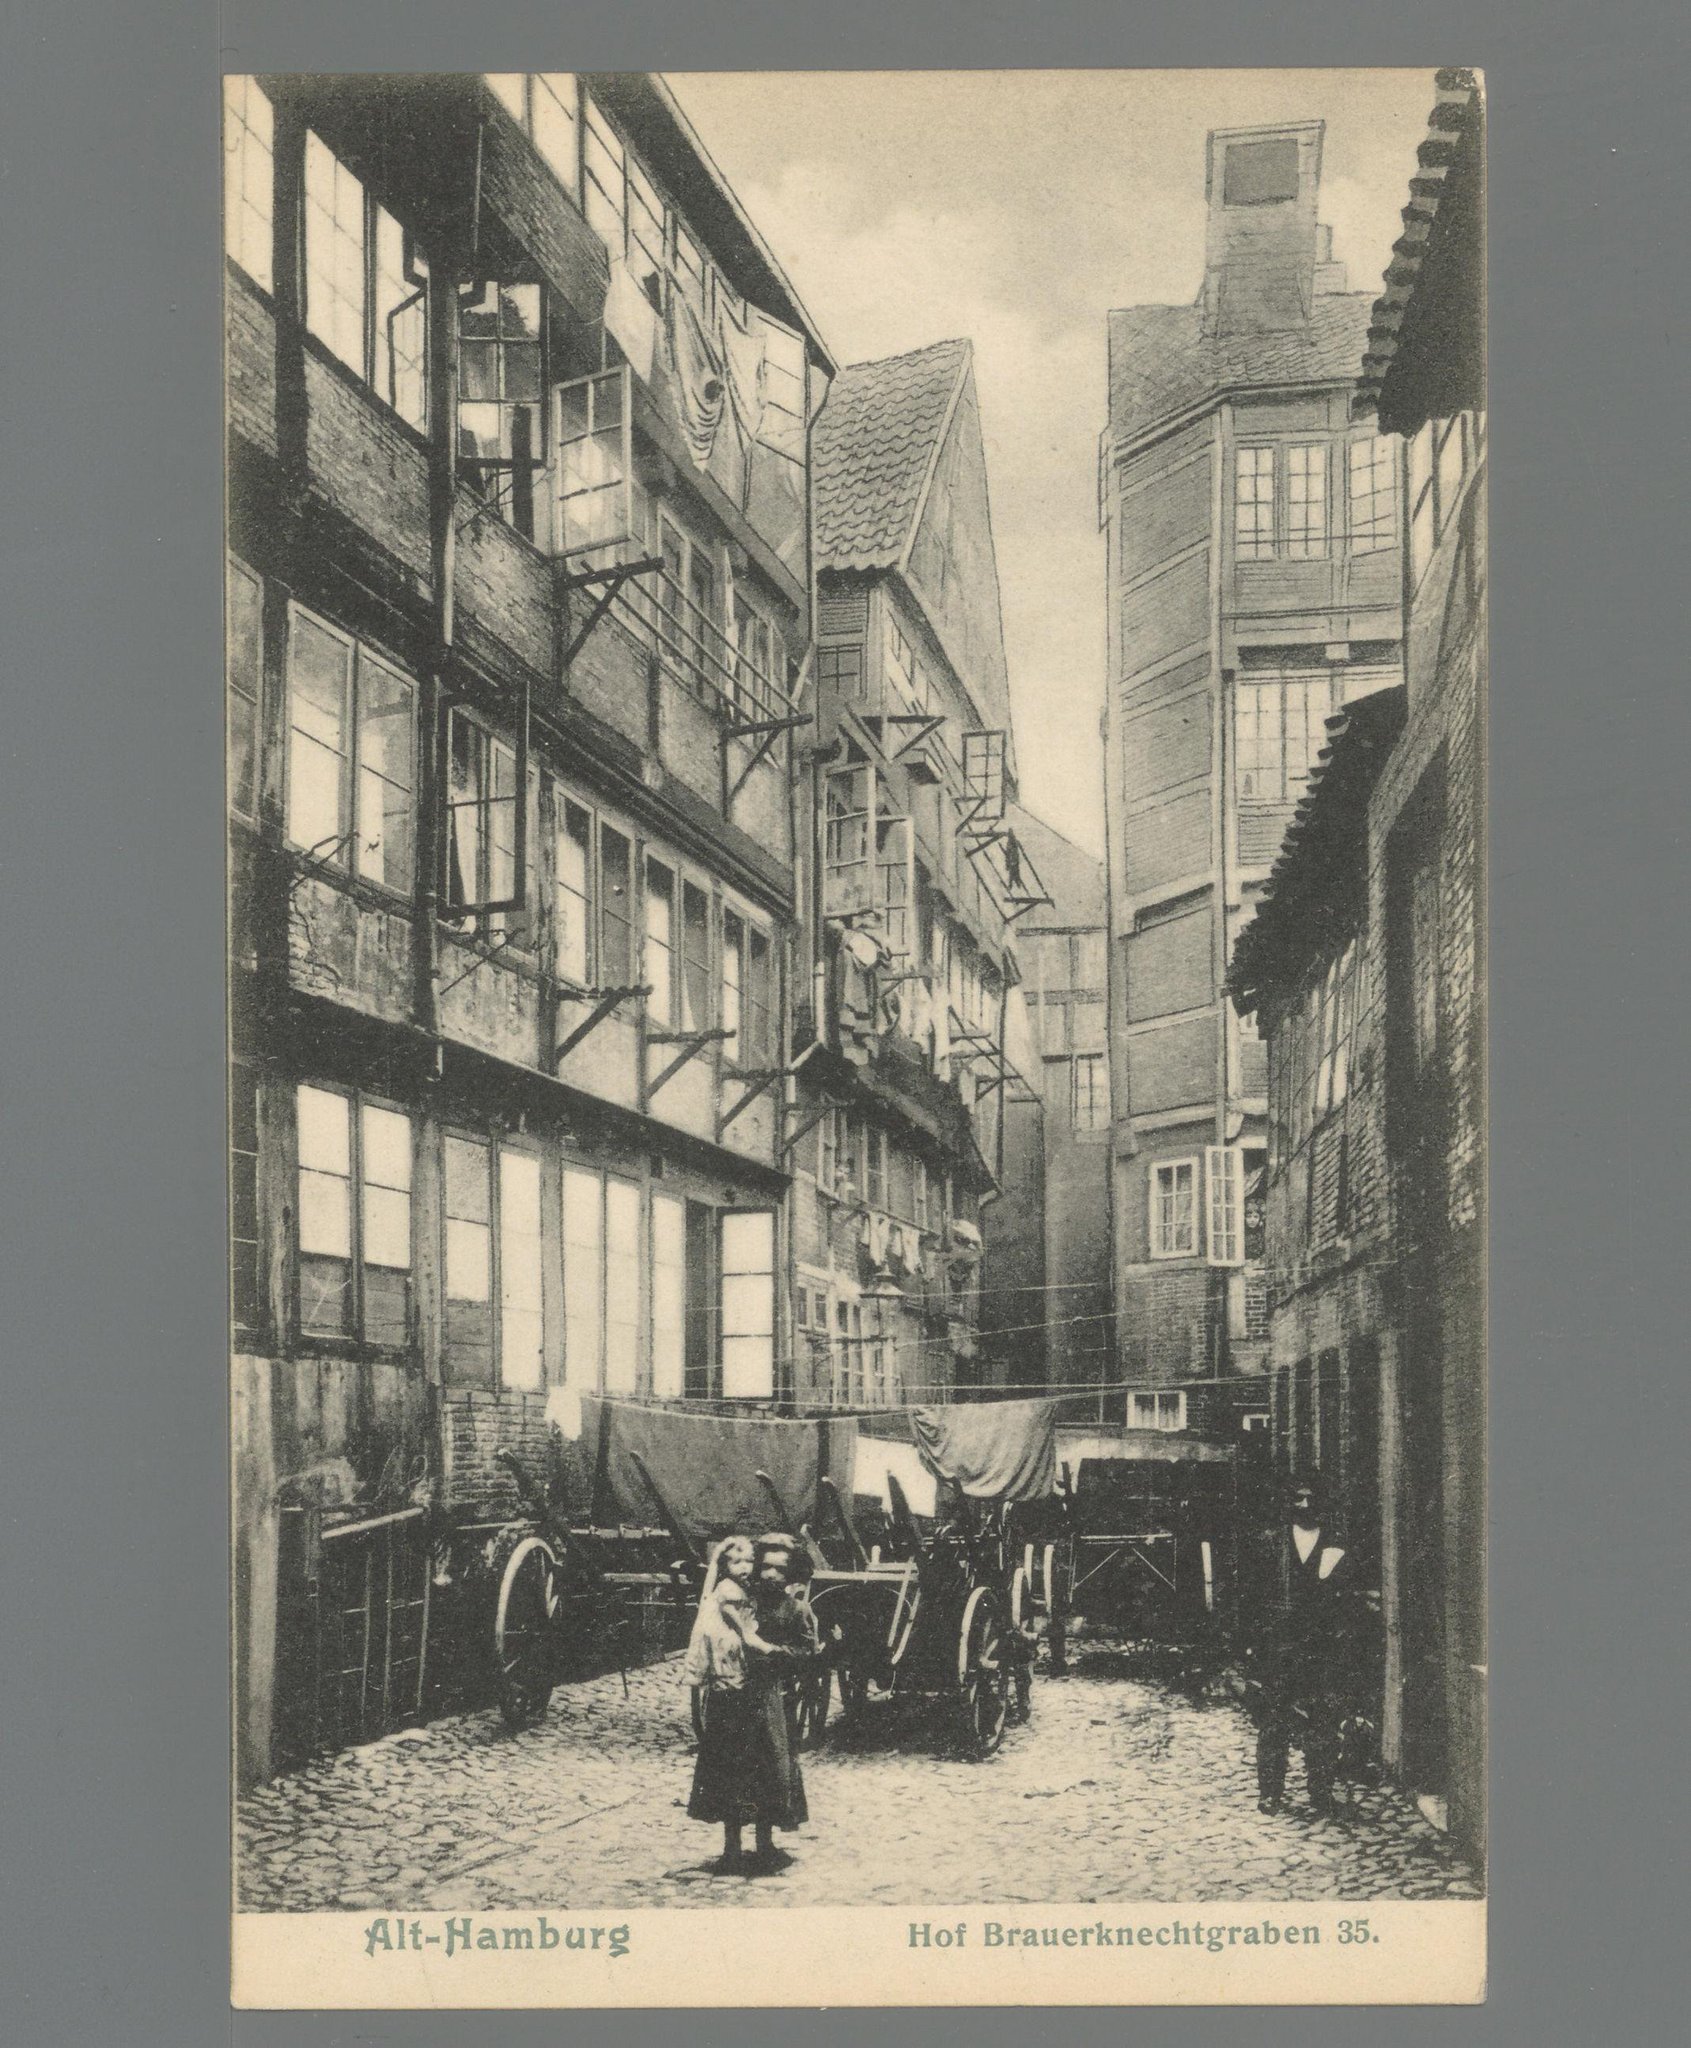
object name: ansichtkaart, prentbriefkaart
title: Alt-Hamburg. Hof Brauerknechtgraben 35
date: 1905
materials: cardboard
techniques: photograph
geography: hamburg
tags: street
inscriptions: date